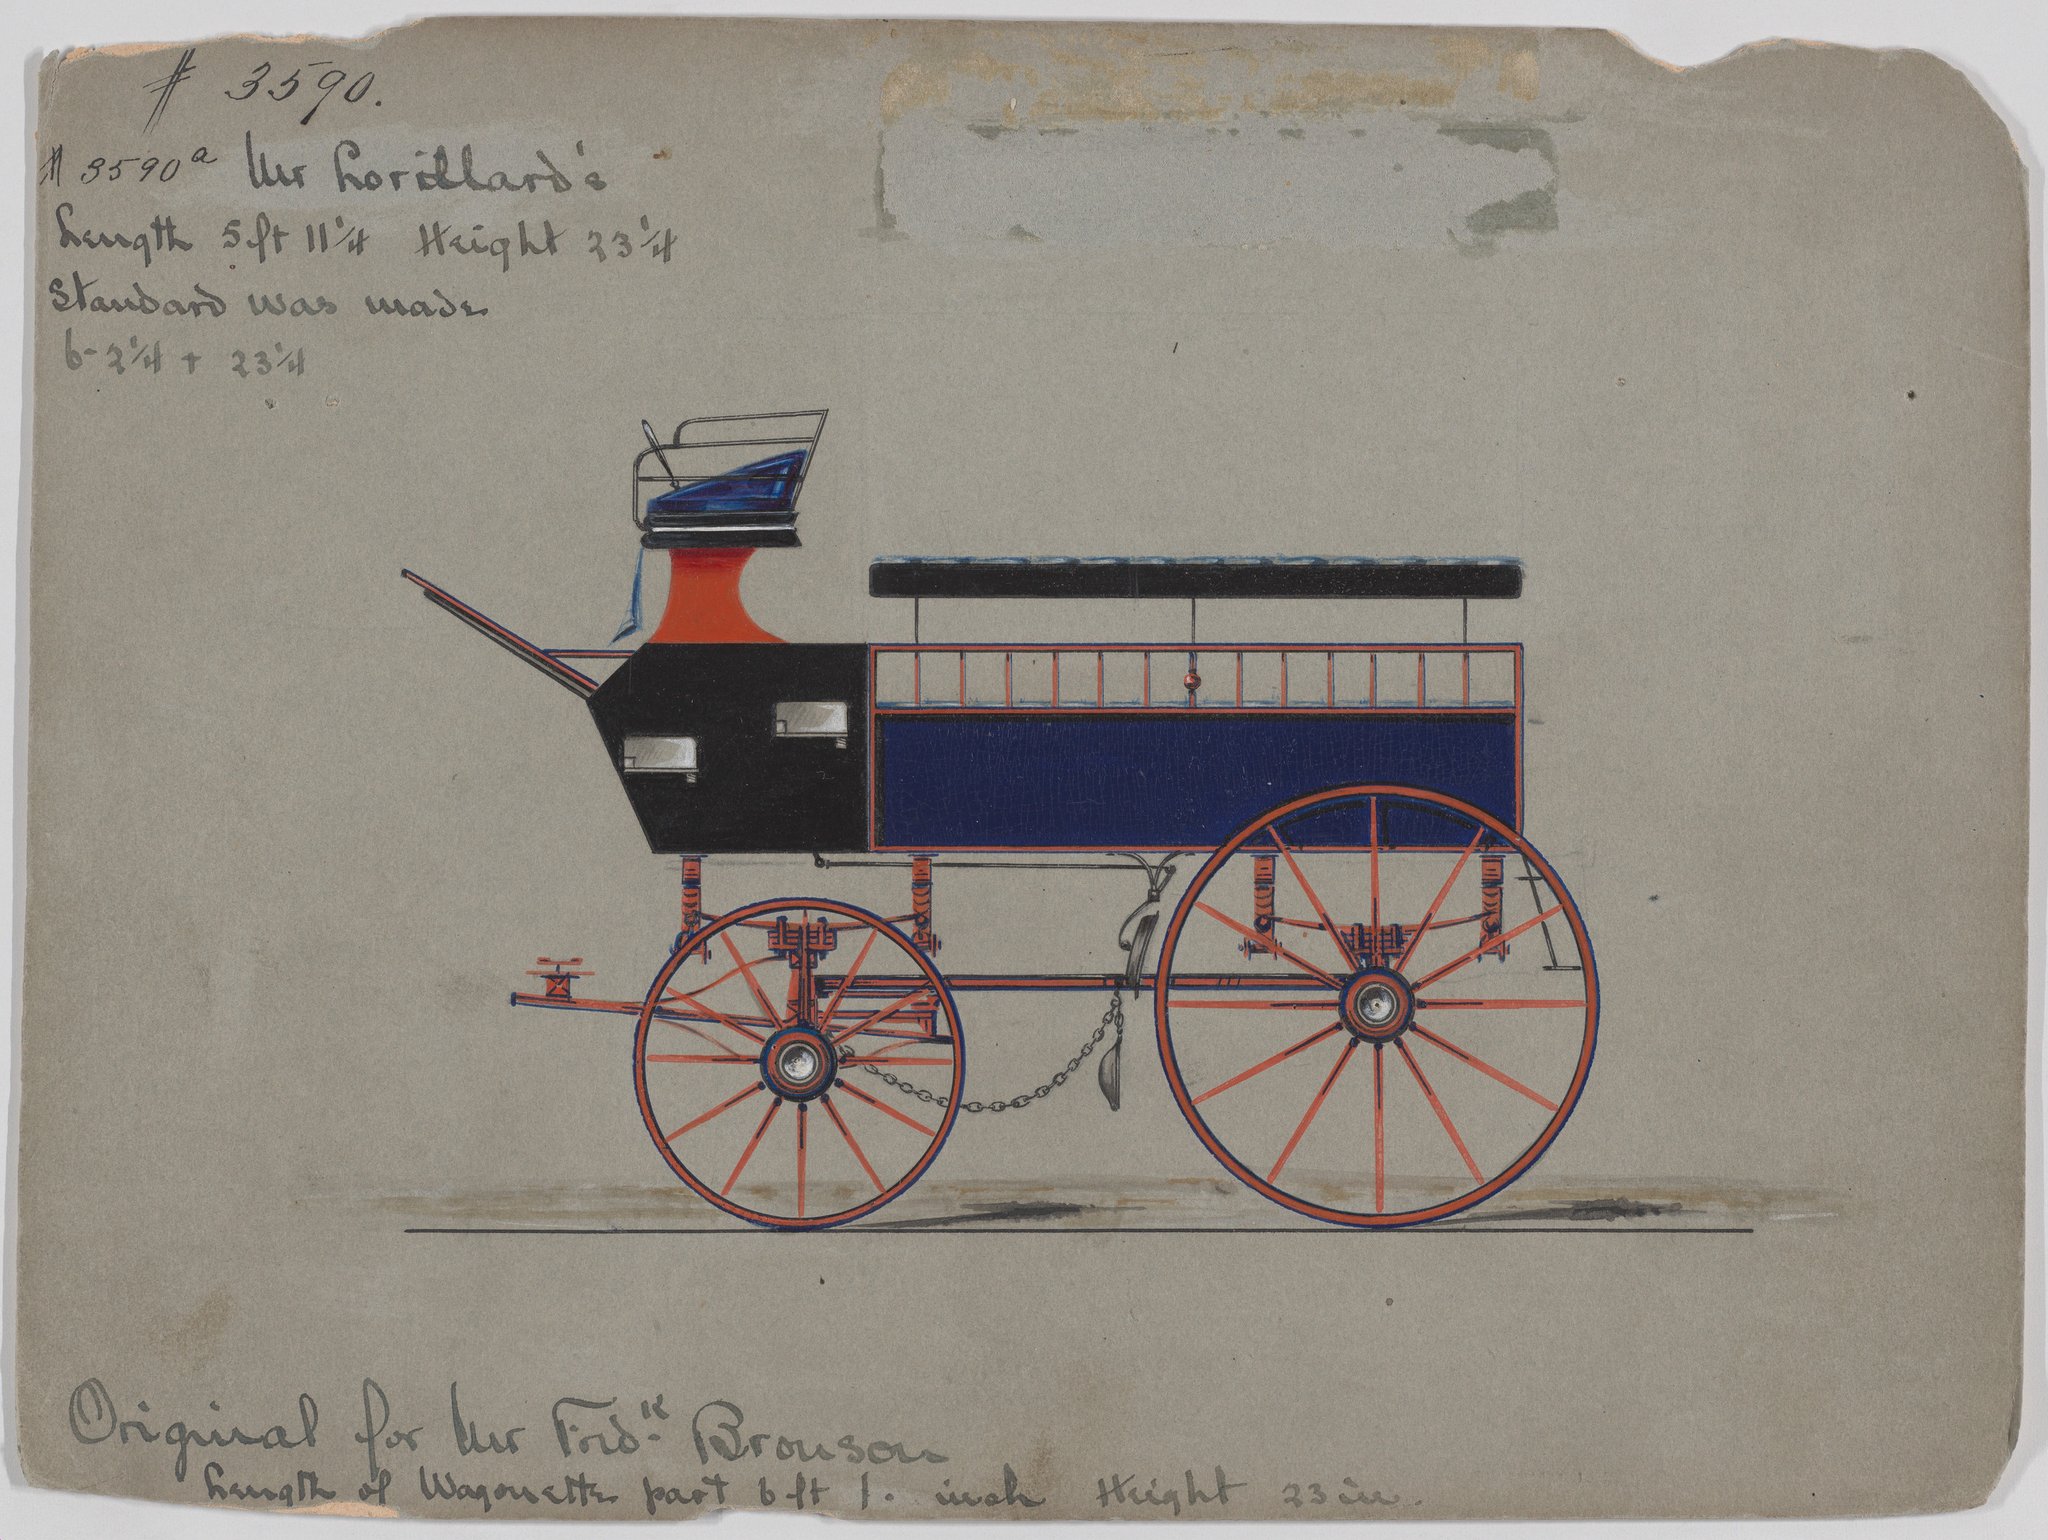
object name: drawing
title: Wagonette Break #3590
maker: brewster & co.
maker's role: manufacturer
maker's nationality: american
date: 1880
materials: gouache, gum arabic, ink, watercolor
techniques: pen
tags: carriages